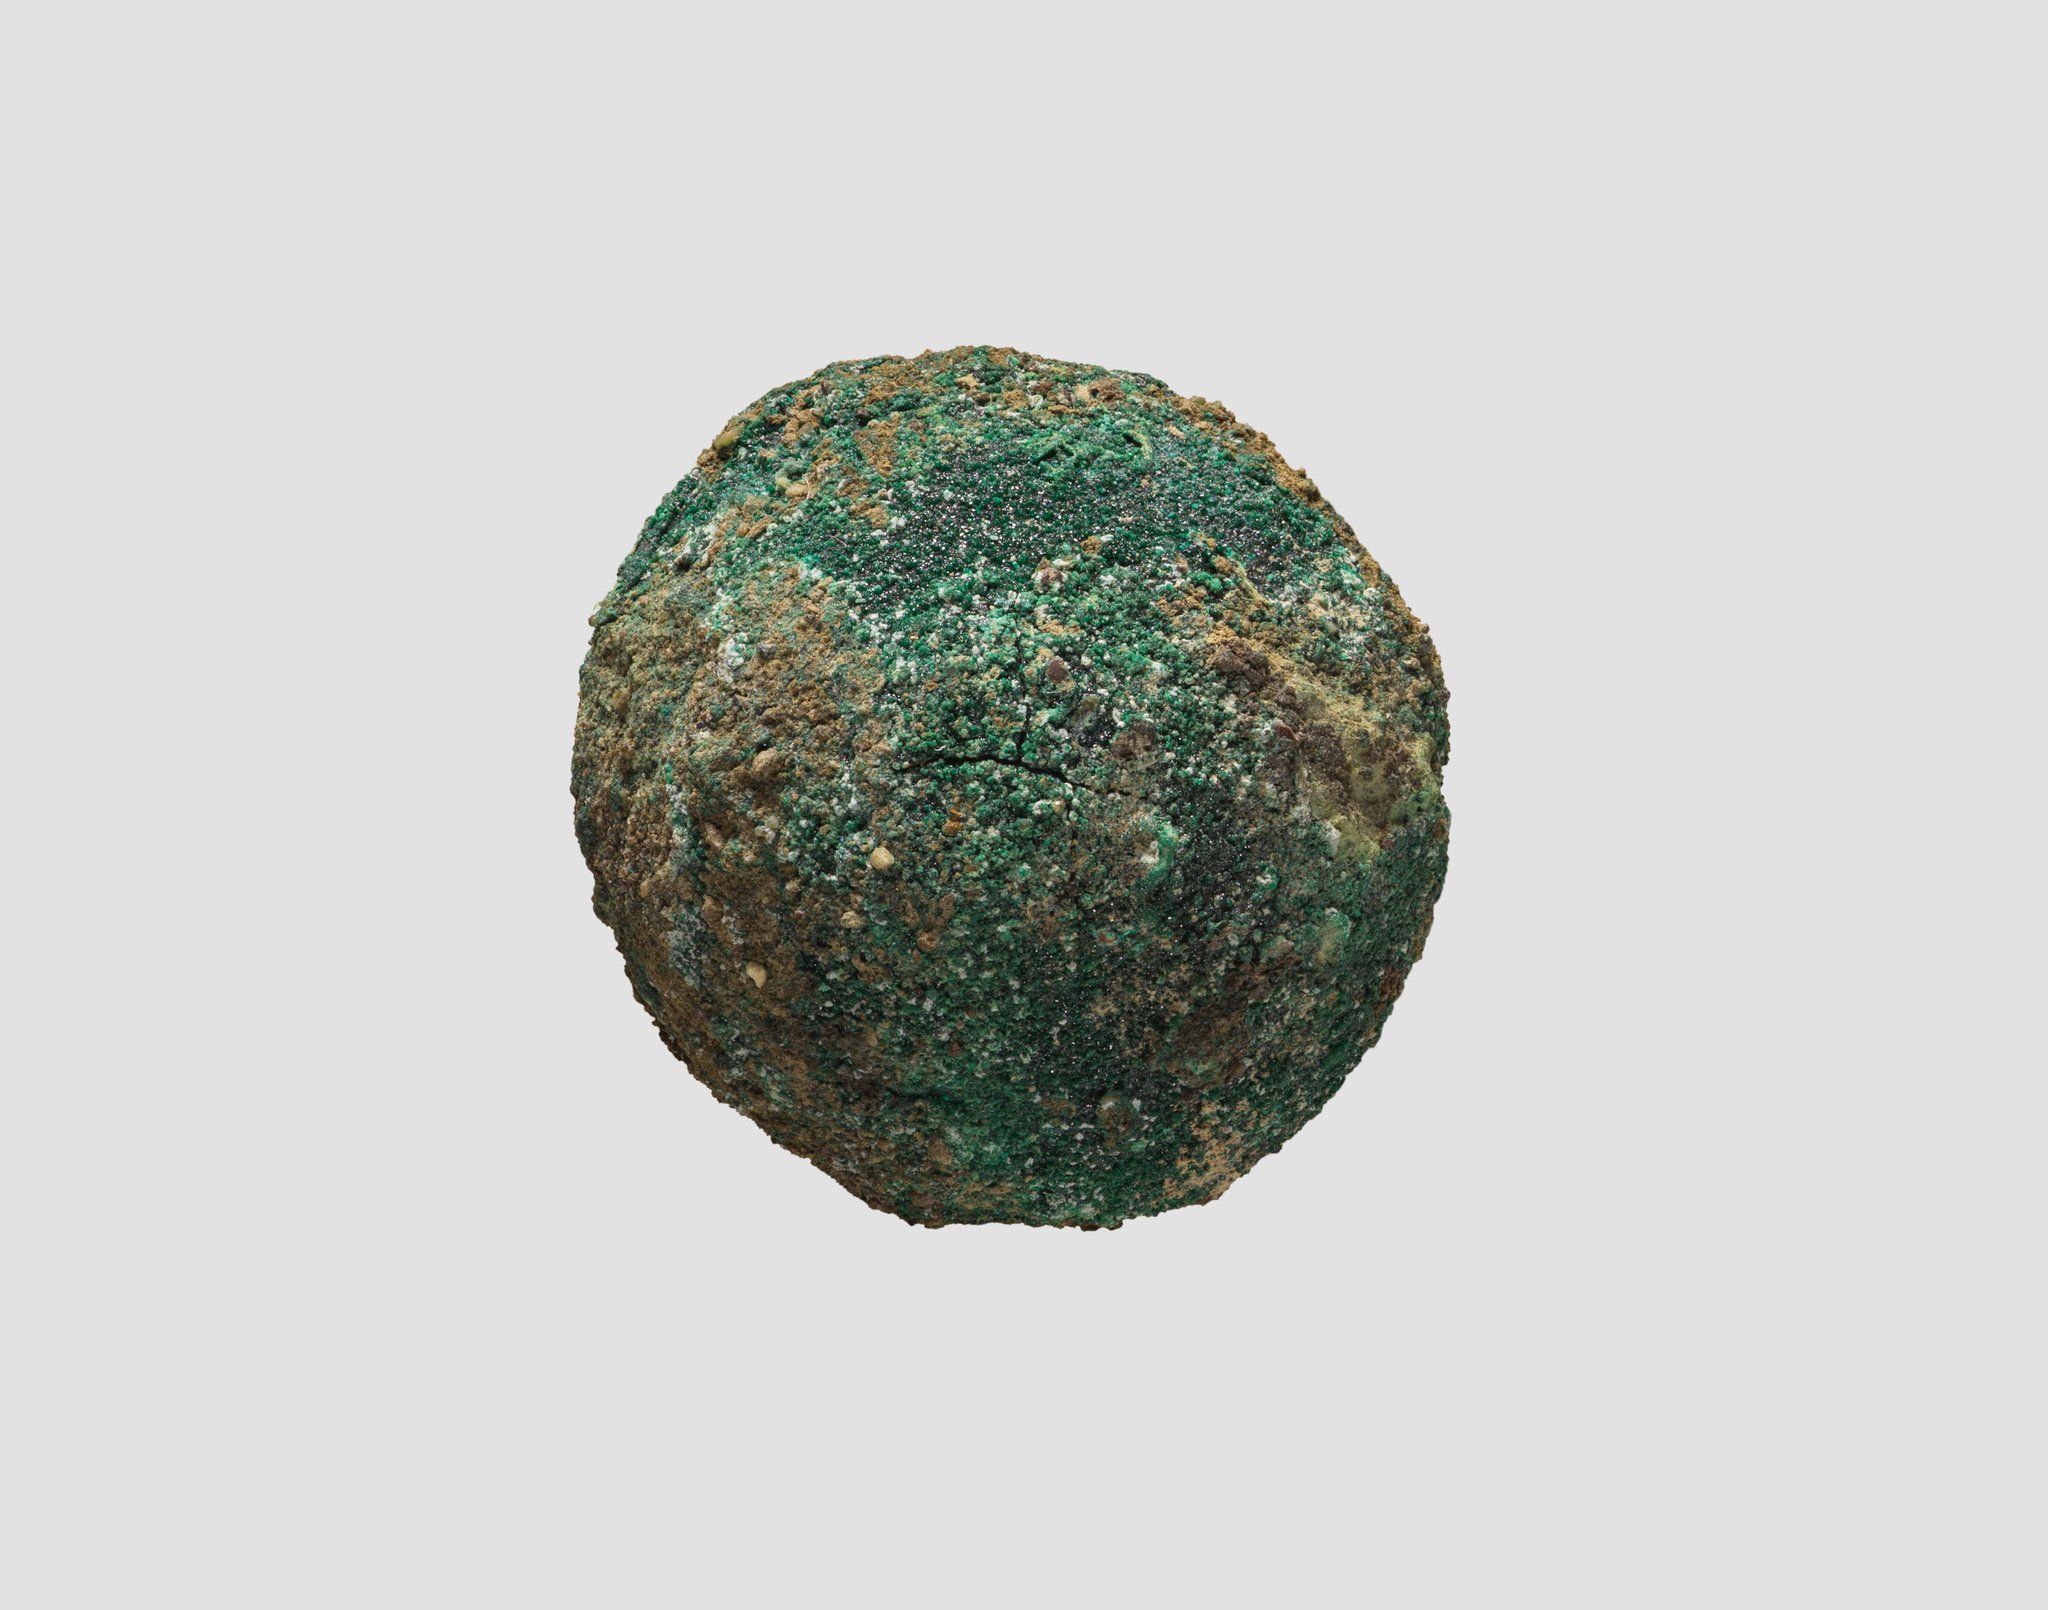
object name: stud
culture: iranian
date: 900-801 BCE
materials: bronze, copper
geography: iran